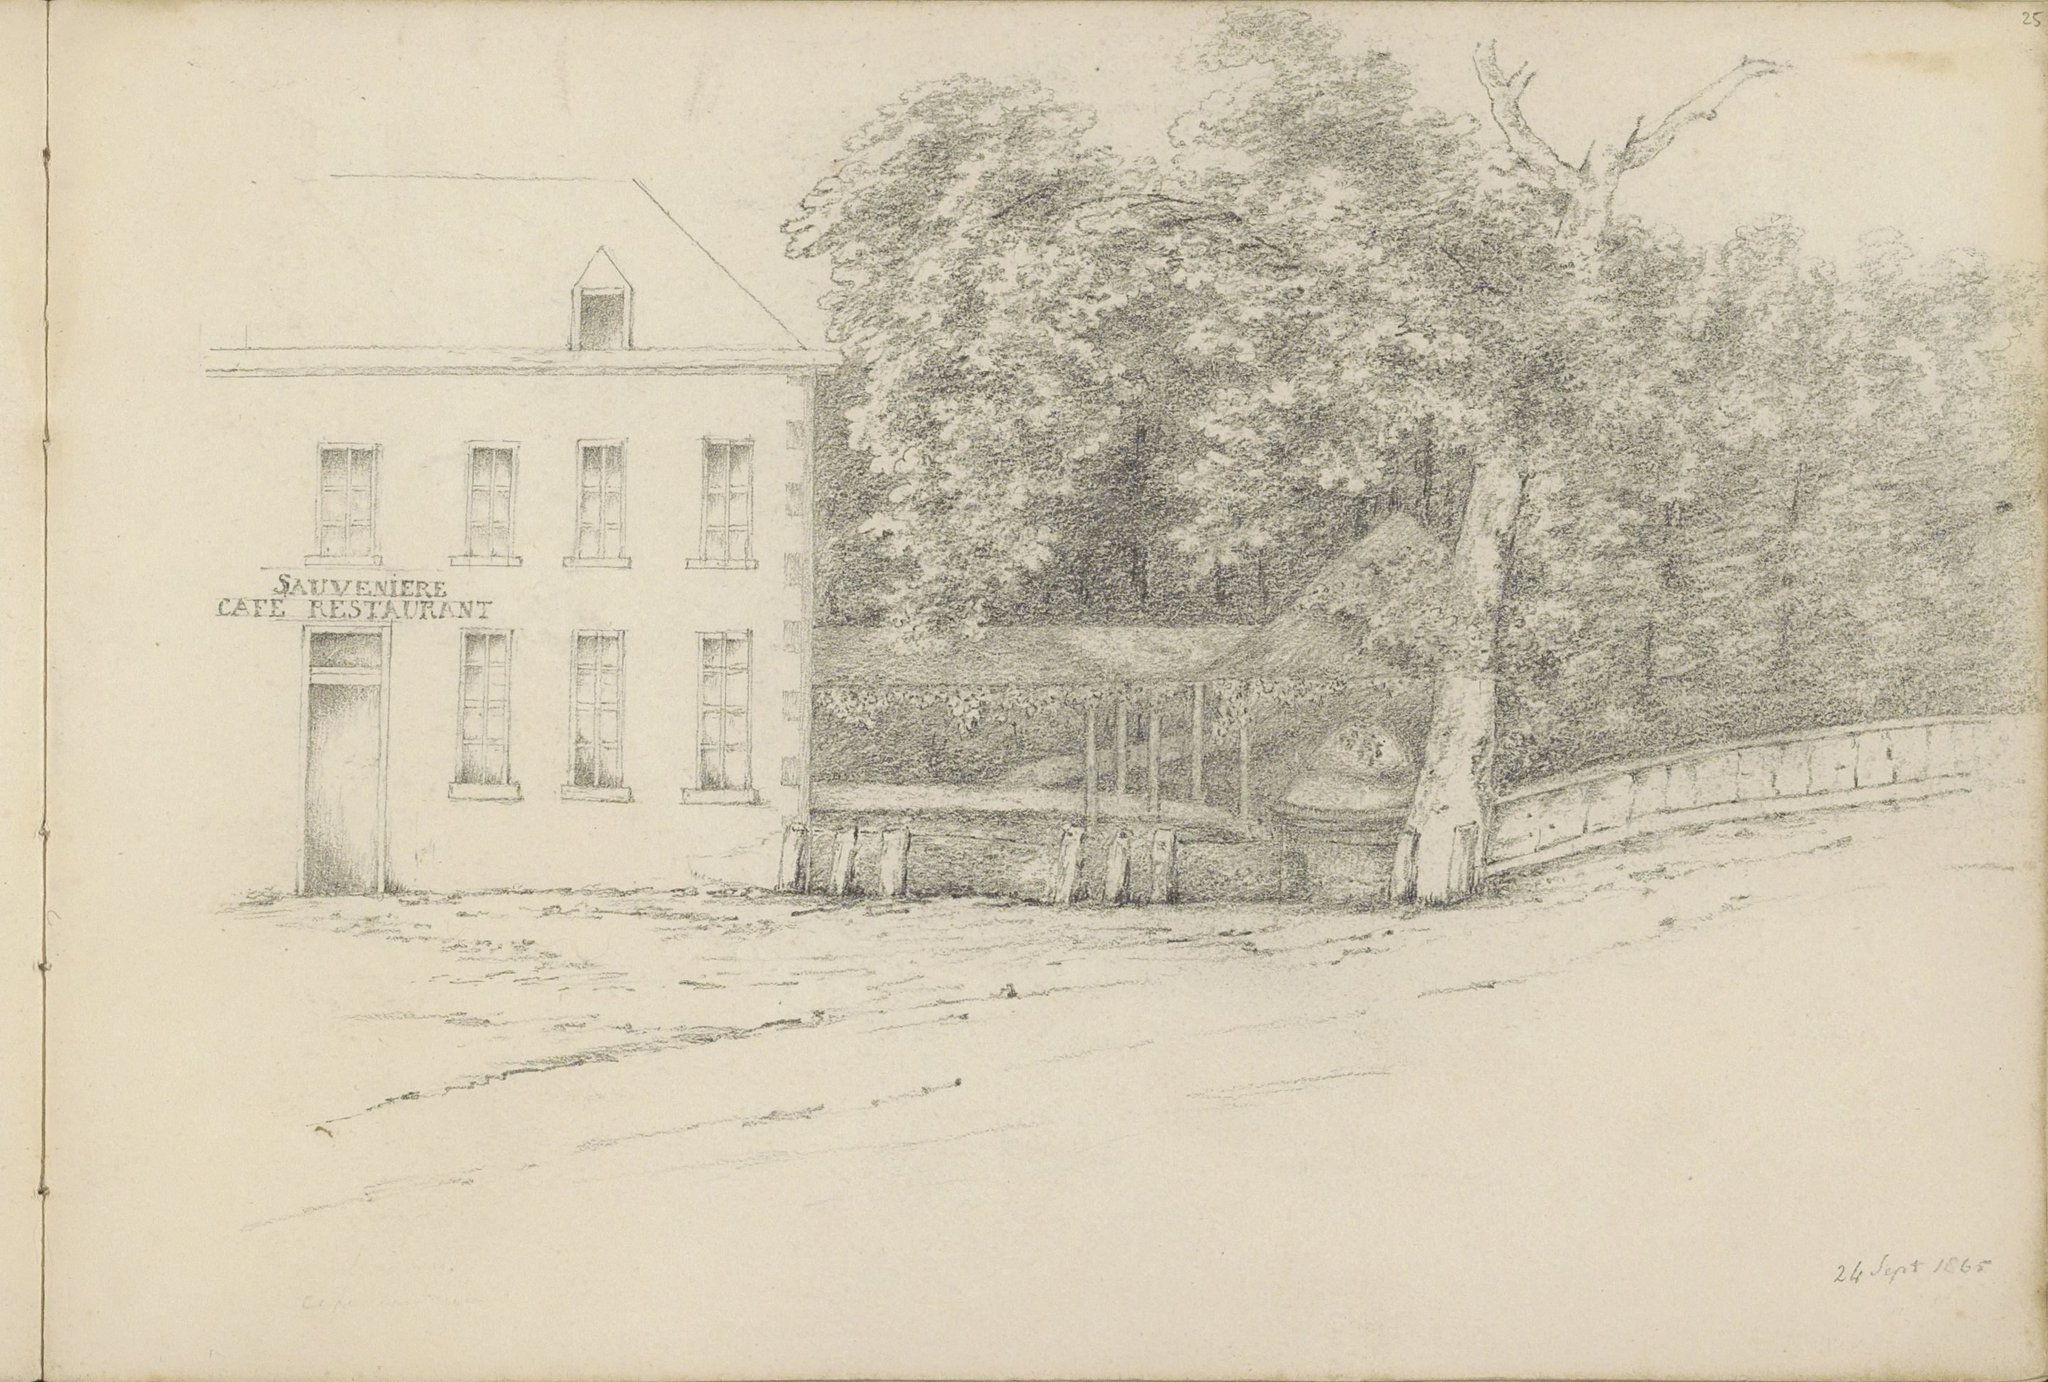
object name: sketchbook leaf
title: Exterieur van een café-restaurant te Sauvenière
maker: Anonymous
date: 1865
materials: paper, pencil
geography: sauvenière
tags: watering-place, spa, restaurant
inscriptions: date: ‘24 Sept 1865’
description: Het café-restaurant ligt in een boomrijke omgeving met rechts de beroemde bron van Sauvenière. Blad 25 recto uit een schetsboek met 45 bladen.